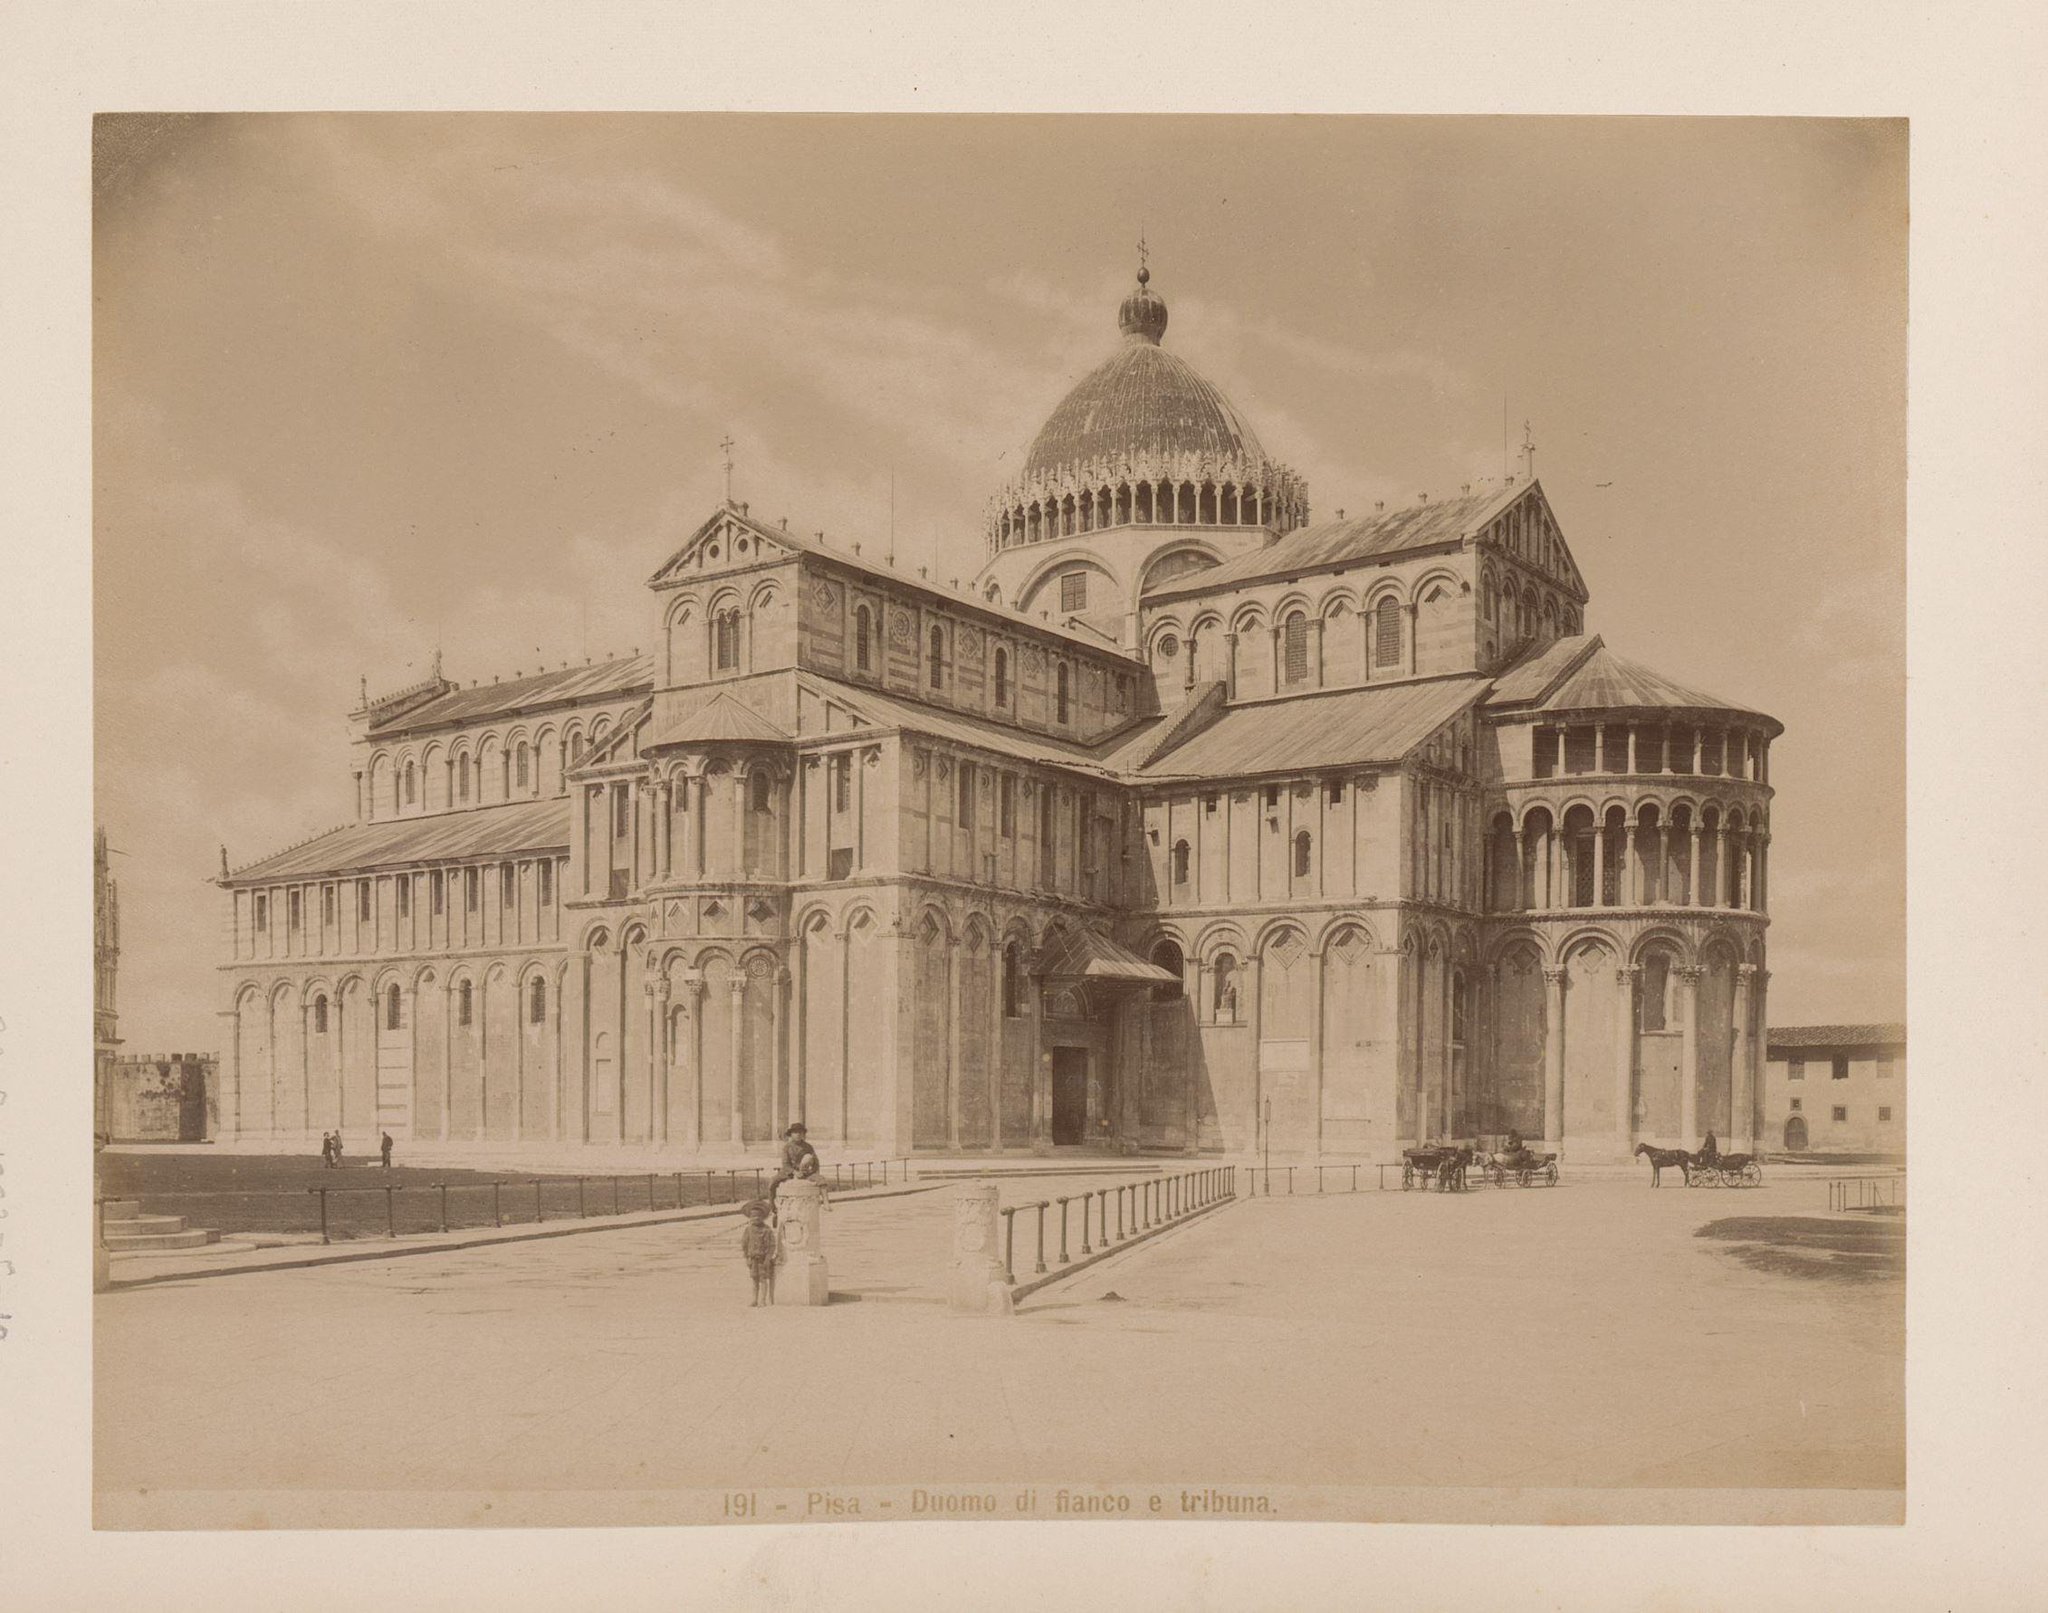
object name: photograph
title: Pisa. Duomo di fianco e tribuno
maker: giacomo brogi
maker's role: fotograaf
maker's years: 1822-1881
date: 1860-1881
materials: paper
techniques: albumen print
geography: pisa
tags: church (exterior)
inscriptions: number: ‘191’